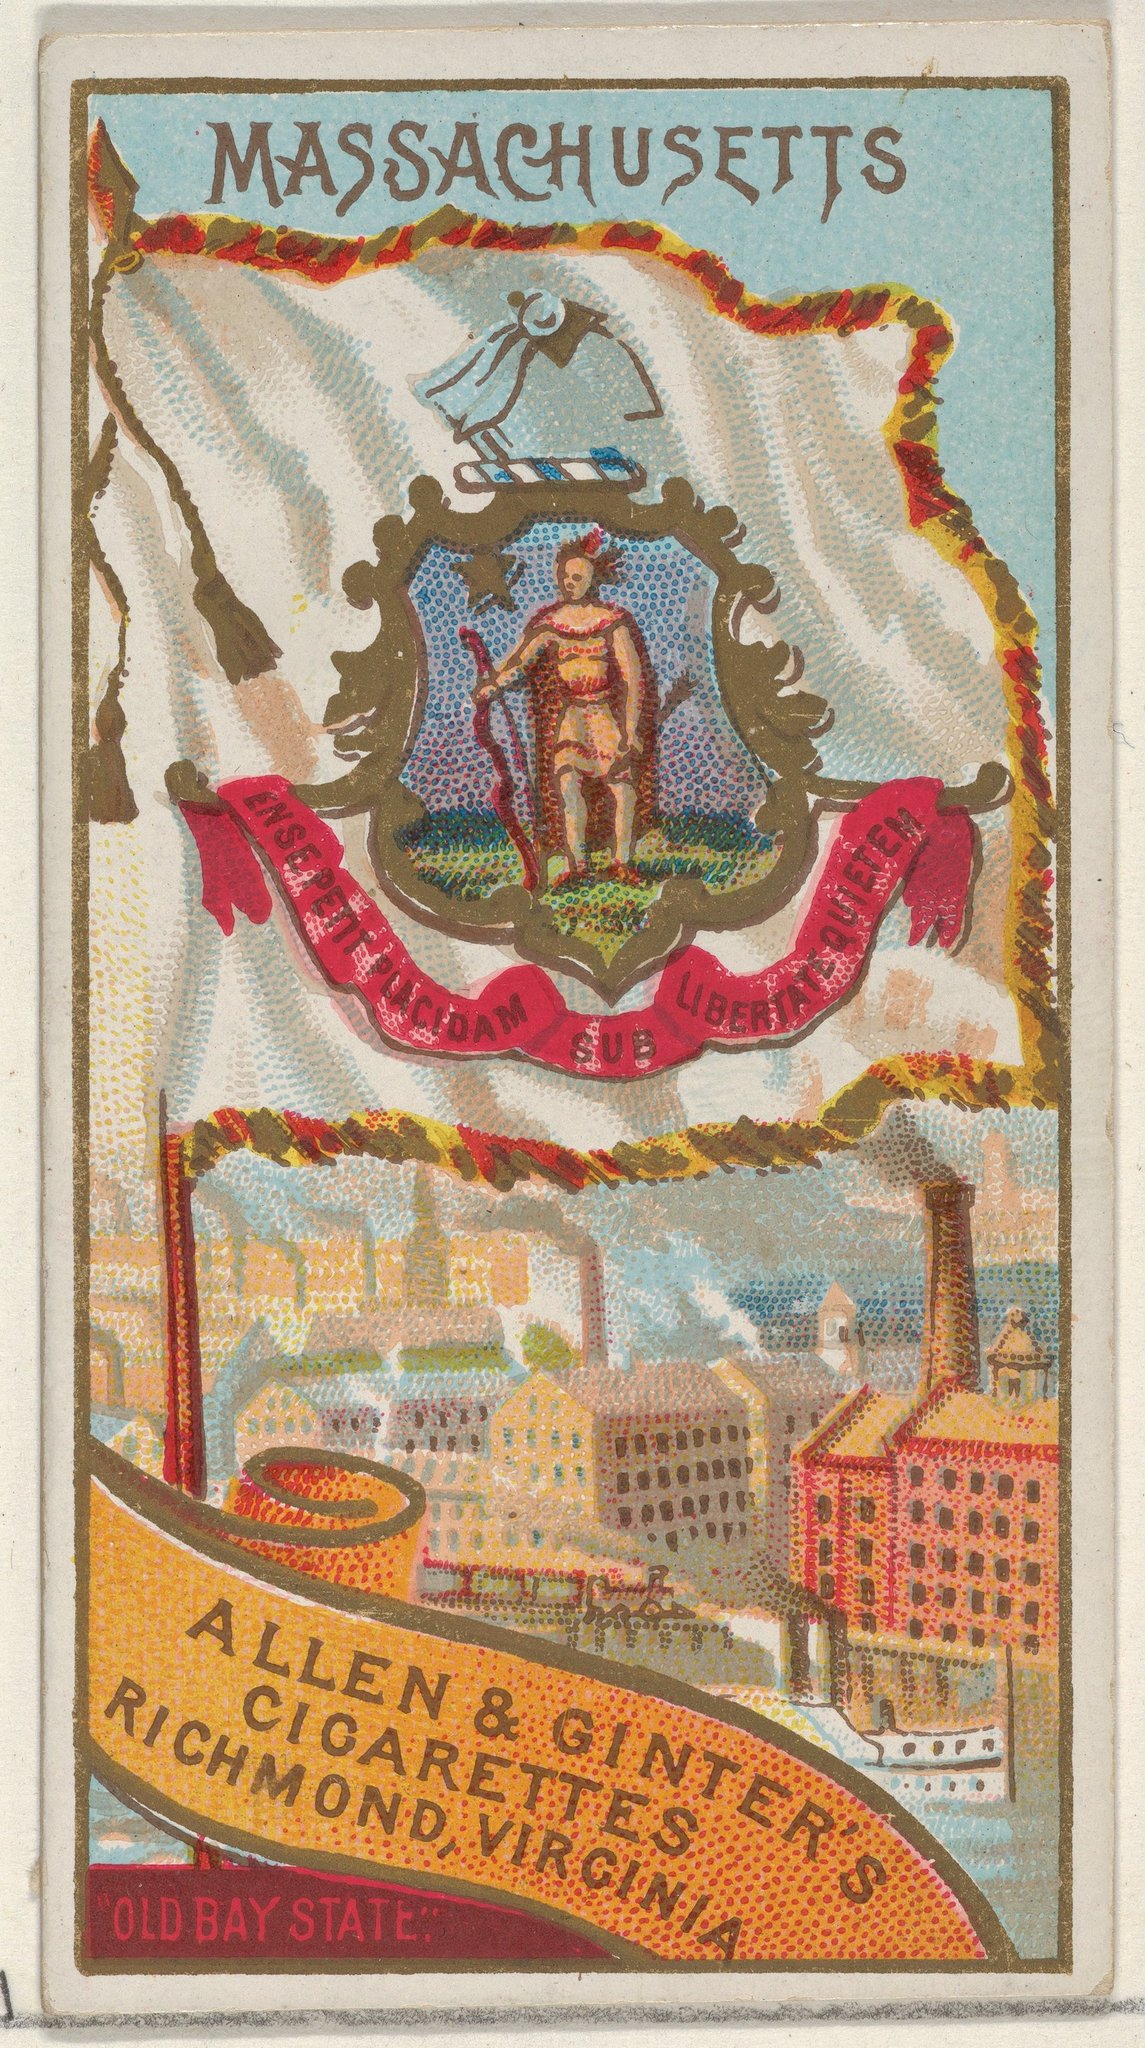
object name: print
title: Massachusetts, from Flags of the States and Territories (N11) for Allen & Ginter Cigarettes Brands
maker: allen & ginter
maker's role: publisher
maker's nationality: american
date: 1888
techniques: color lithograph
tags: flags